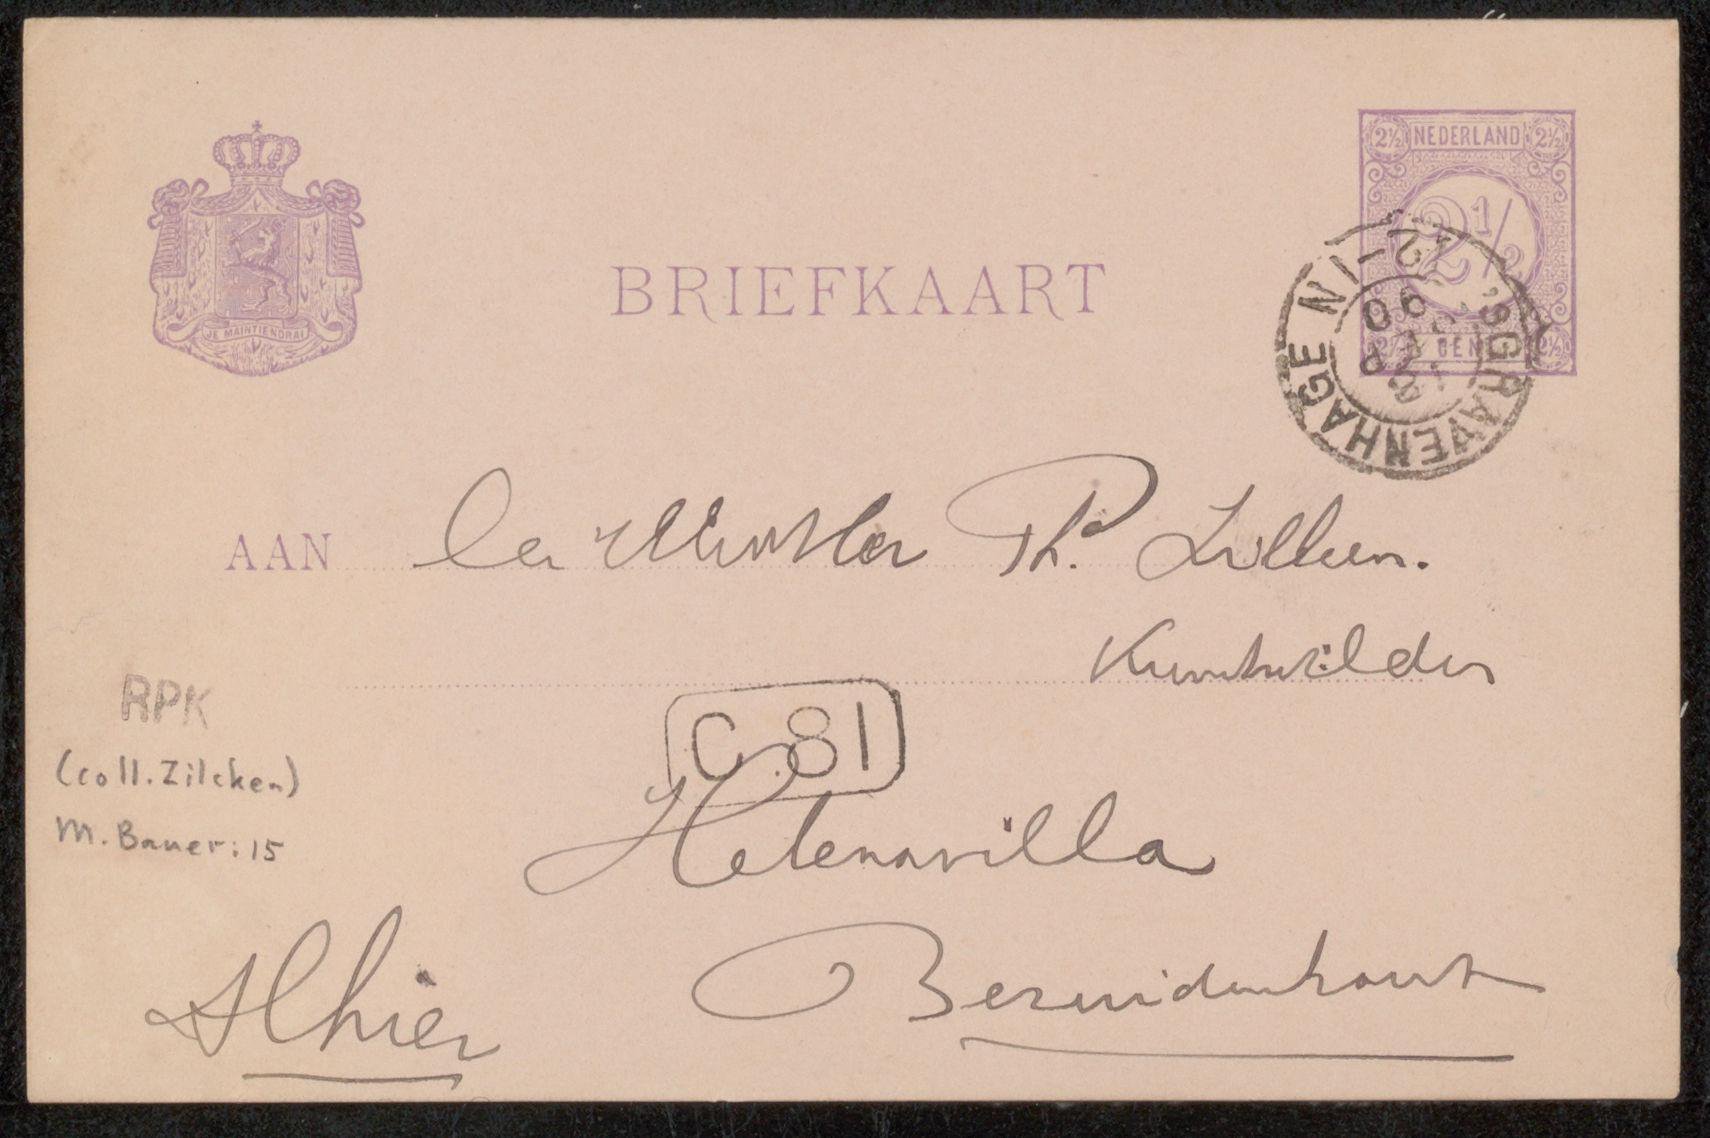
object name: postcard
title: Briefkaart aan Philip Zilcken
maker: marius bauer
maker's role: draughtsman, print maker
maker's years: 1867-1932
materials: cardboard, ink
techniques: pen, writing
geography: the hague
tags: painter, philip zilcken, etching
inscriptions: collector's mark: ‘RPK’